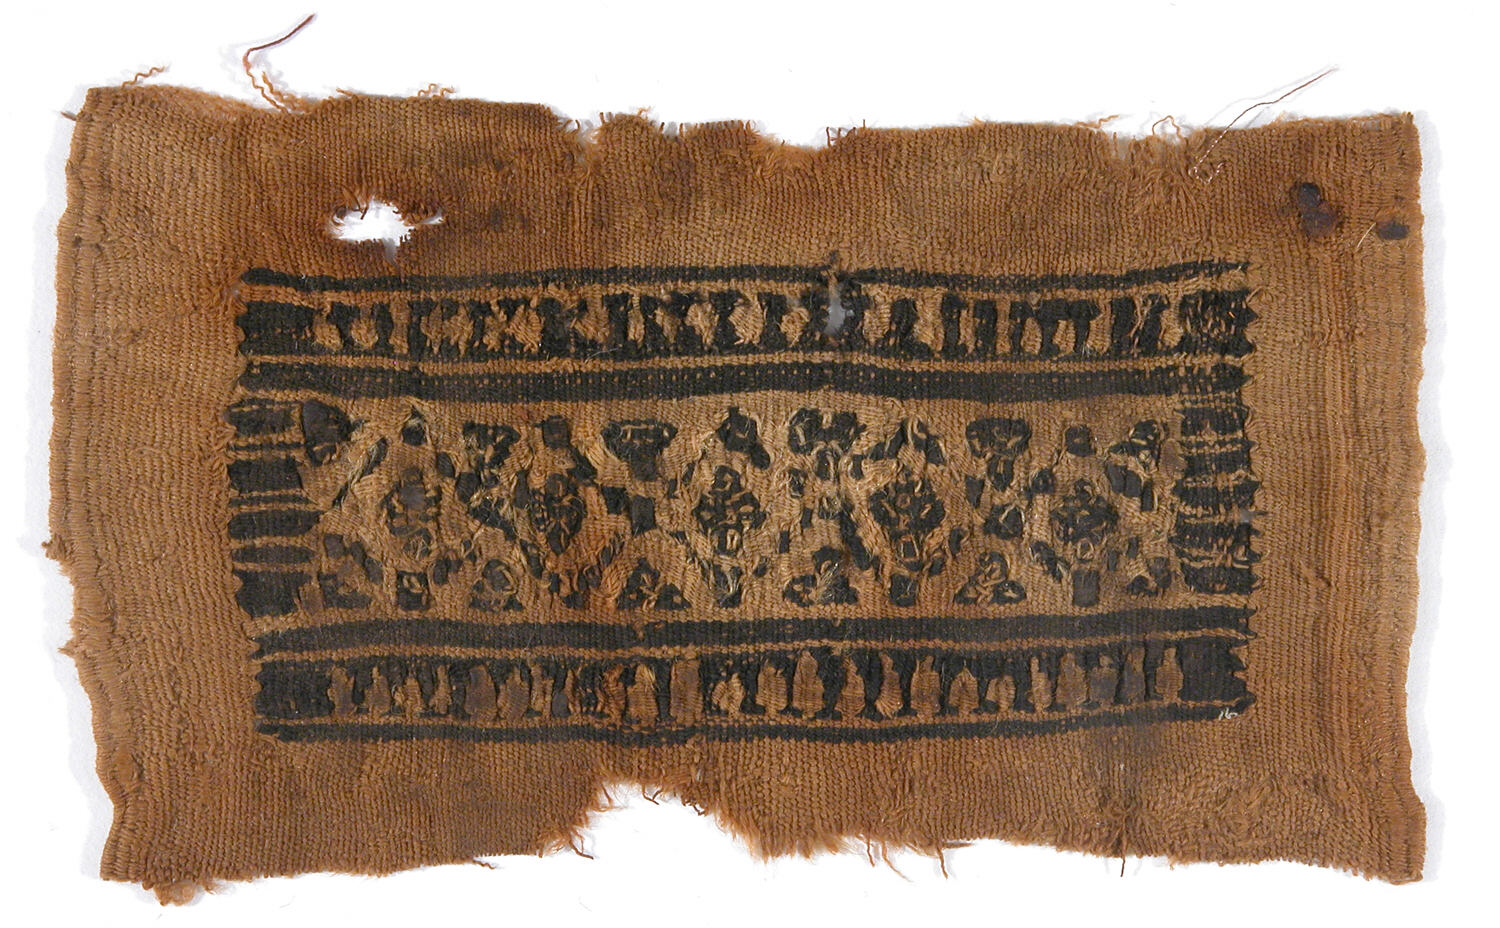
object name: fragment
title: Textile Fragment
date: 301-500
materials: wool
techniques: tapestry, weave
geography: egypt